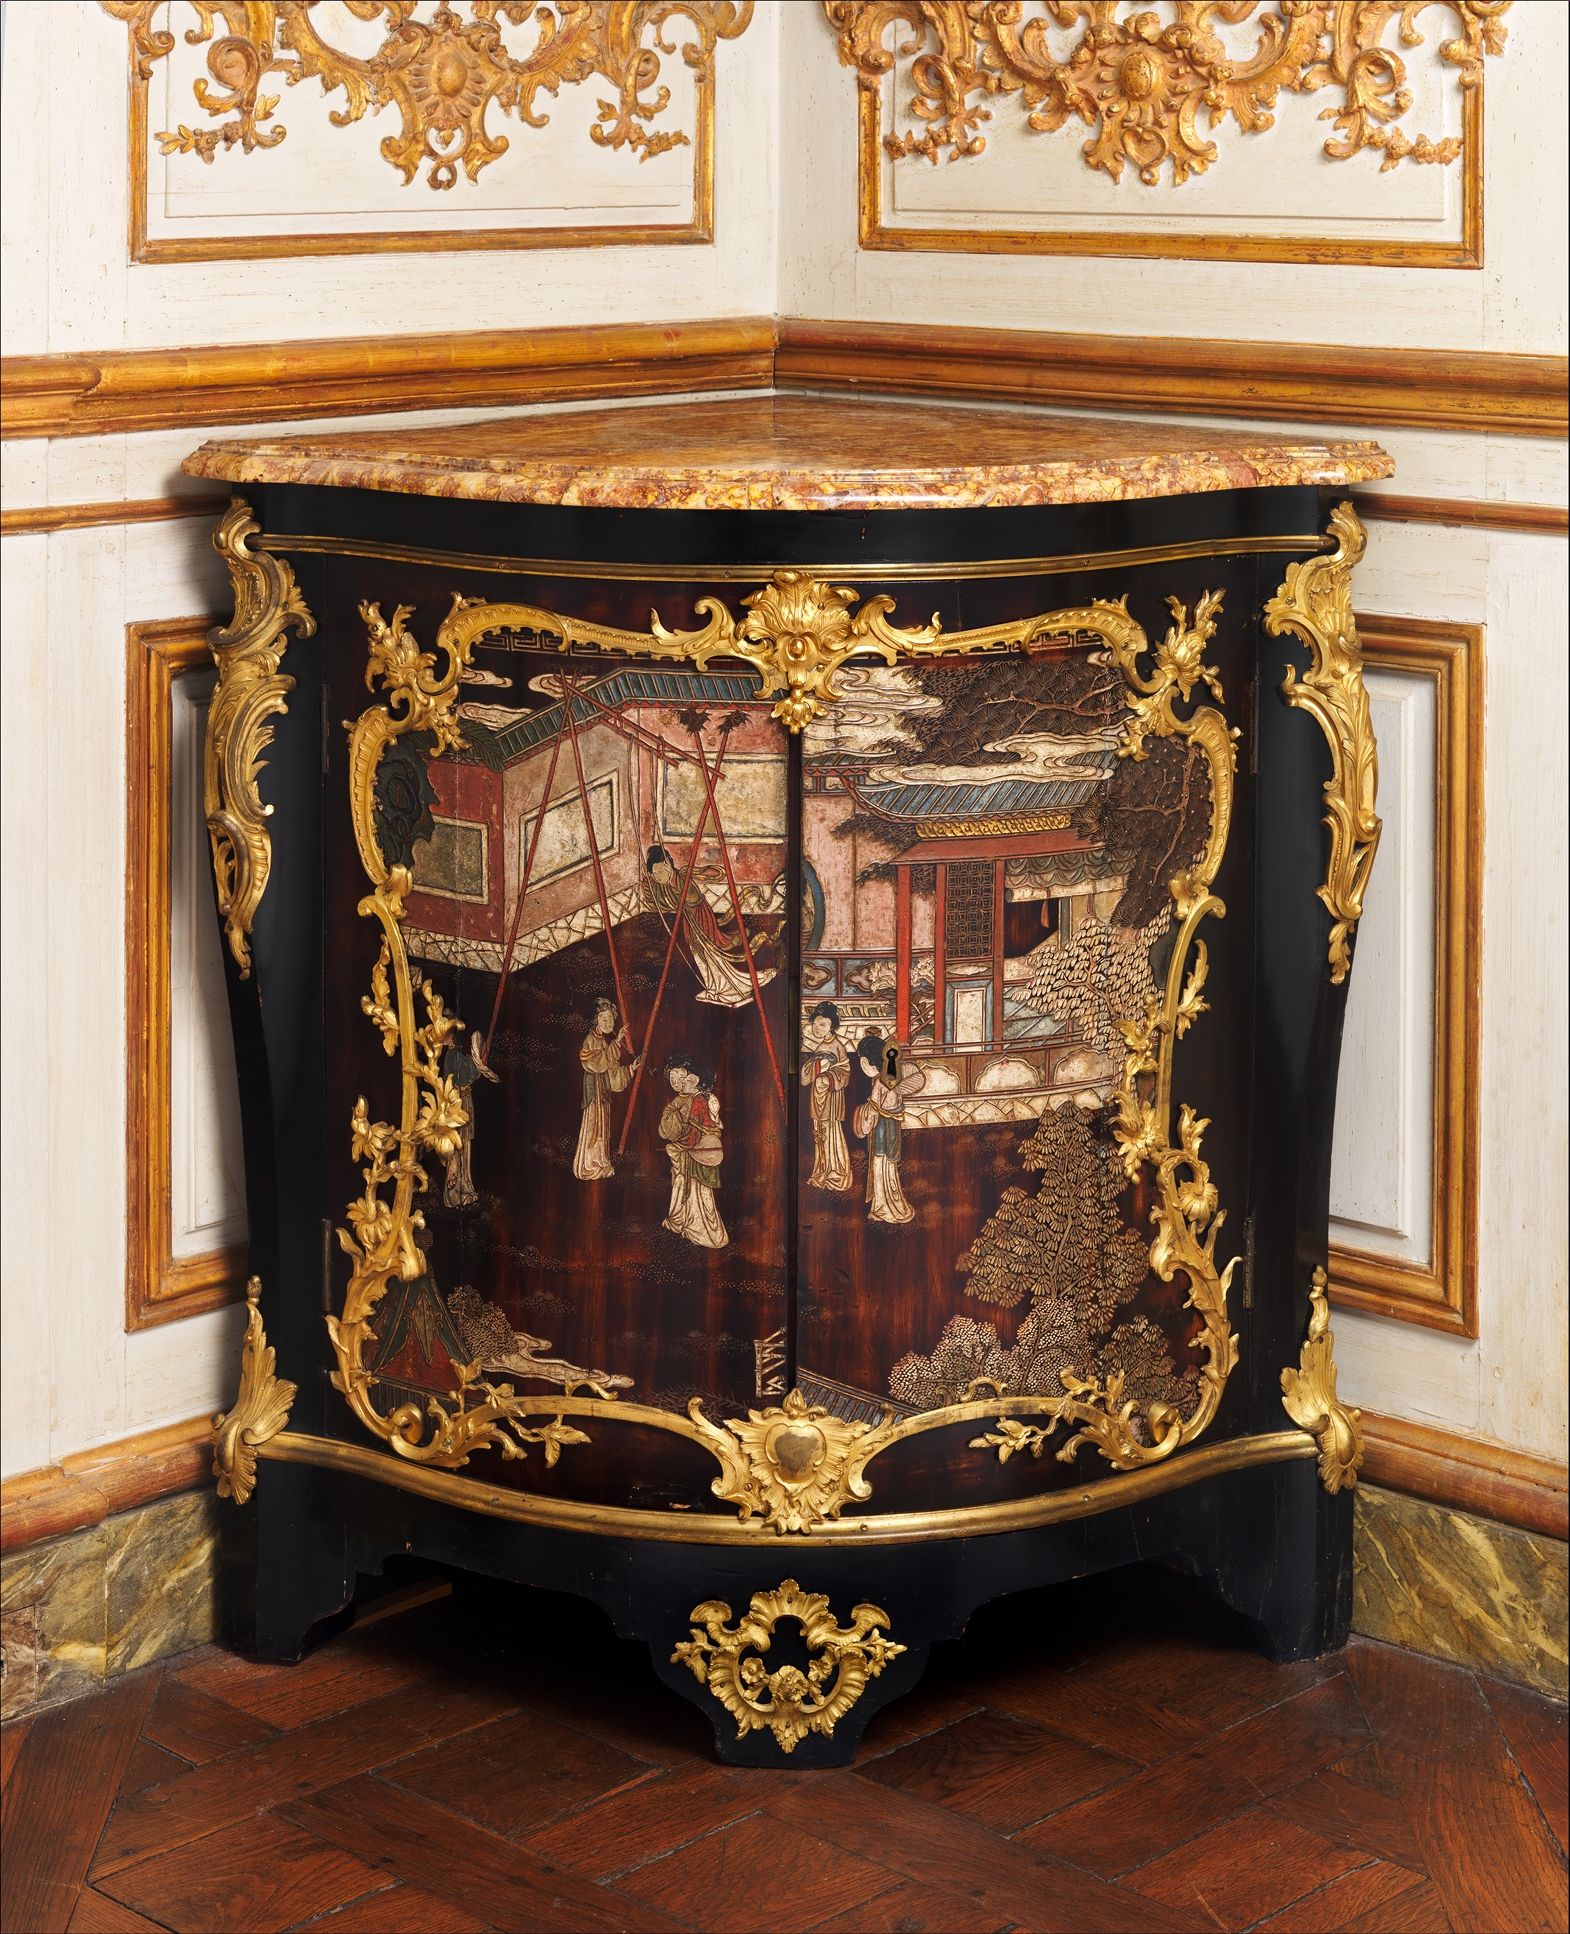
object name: corner cabinet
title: Corner cabinet (encoignure) (one of a pair)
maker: bernard ii van risenburgh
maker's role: maker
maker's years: 1696-1767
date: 1745-1749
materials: wood, gilt bronze, lacquer, marble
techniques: veneering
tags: women